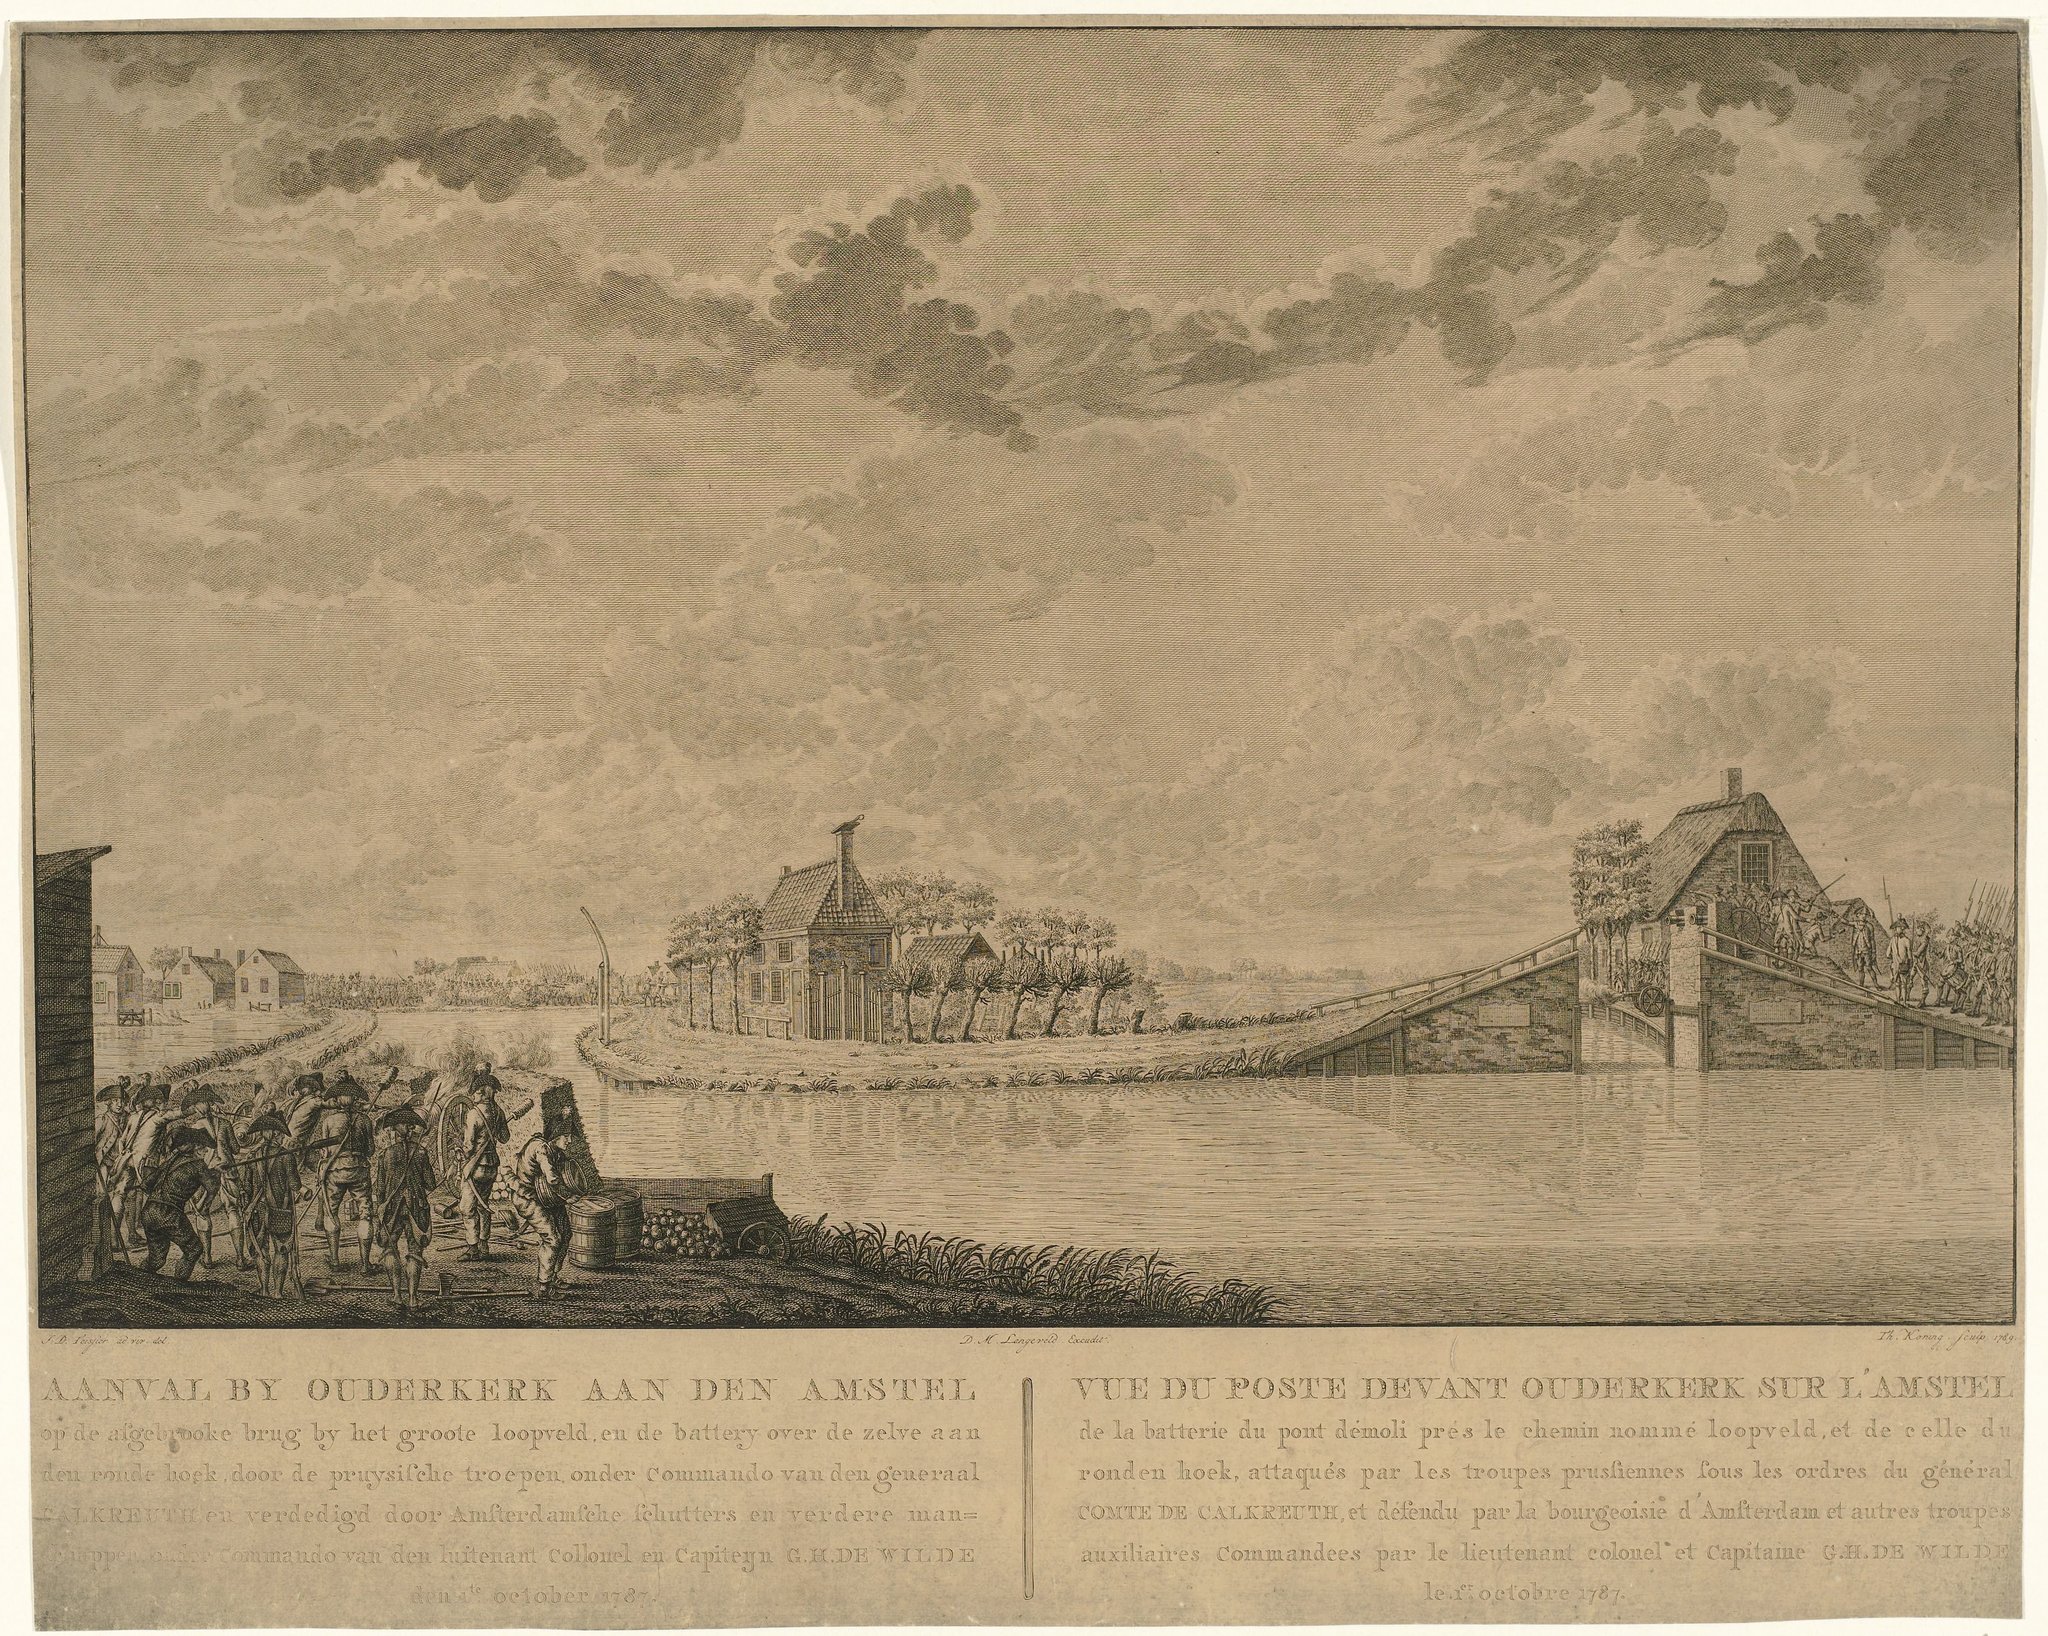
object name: print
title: Gevechten met de Pruisische troepen rond Amsterdam in 1787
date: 1789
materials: paper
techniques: engraving, etching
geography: ouderkerk aan de amstel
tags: berlin, (military) attack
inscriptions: collector's mark: Lugt 2228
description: Aanval bij de afgebroken brug bij het grote loopveld in Ouderkerk aan de Amstel door de Pruisische troepen onder commando van generaal Friedrich Adolf von Kalckreuth, verdedigd door Amsterdamse schutters onder commando van kolonel George Hendrik de Wilde, 1 oktober 1787. Onderdeel van een groep van zeven prenten van de gevechten met de Pruissische troepen rond Amsterdam in 1787.